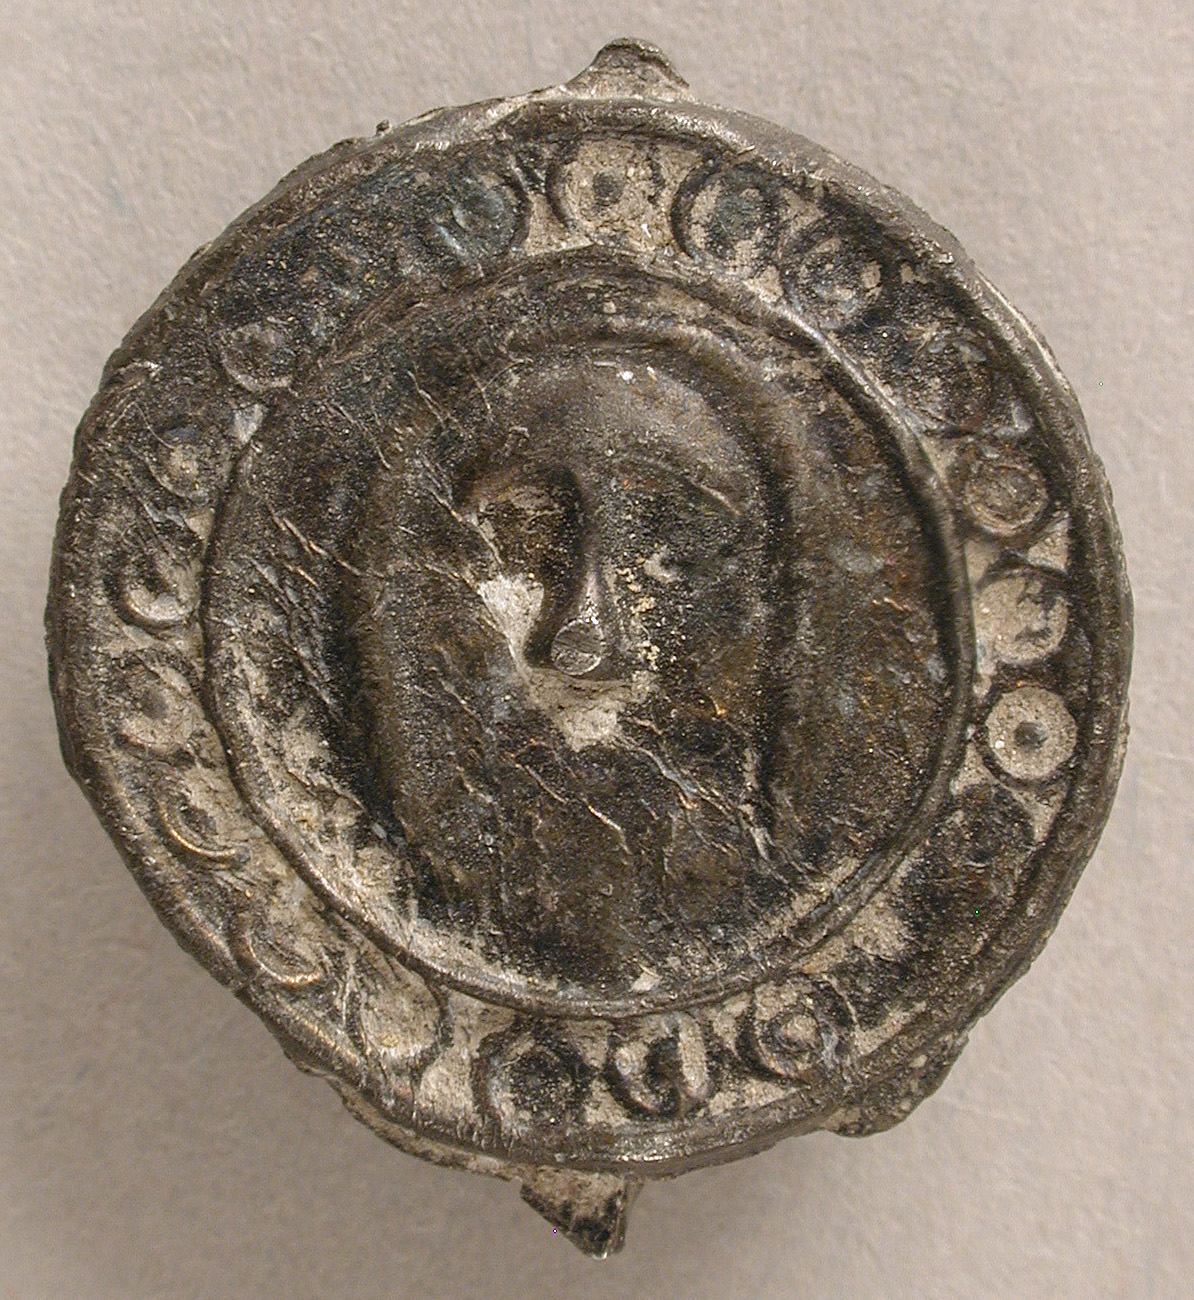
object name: pilgrim's badge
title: Badge with Head of Christ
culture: british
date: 1301-1500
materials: alloy, lead, tin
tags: christ